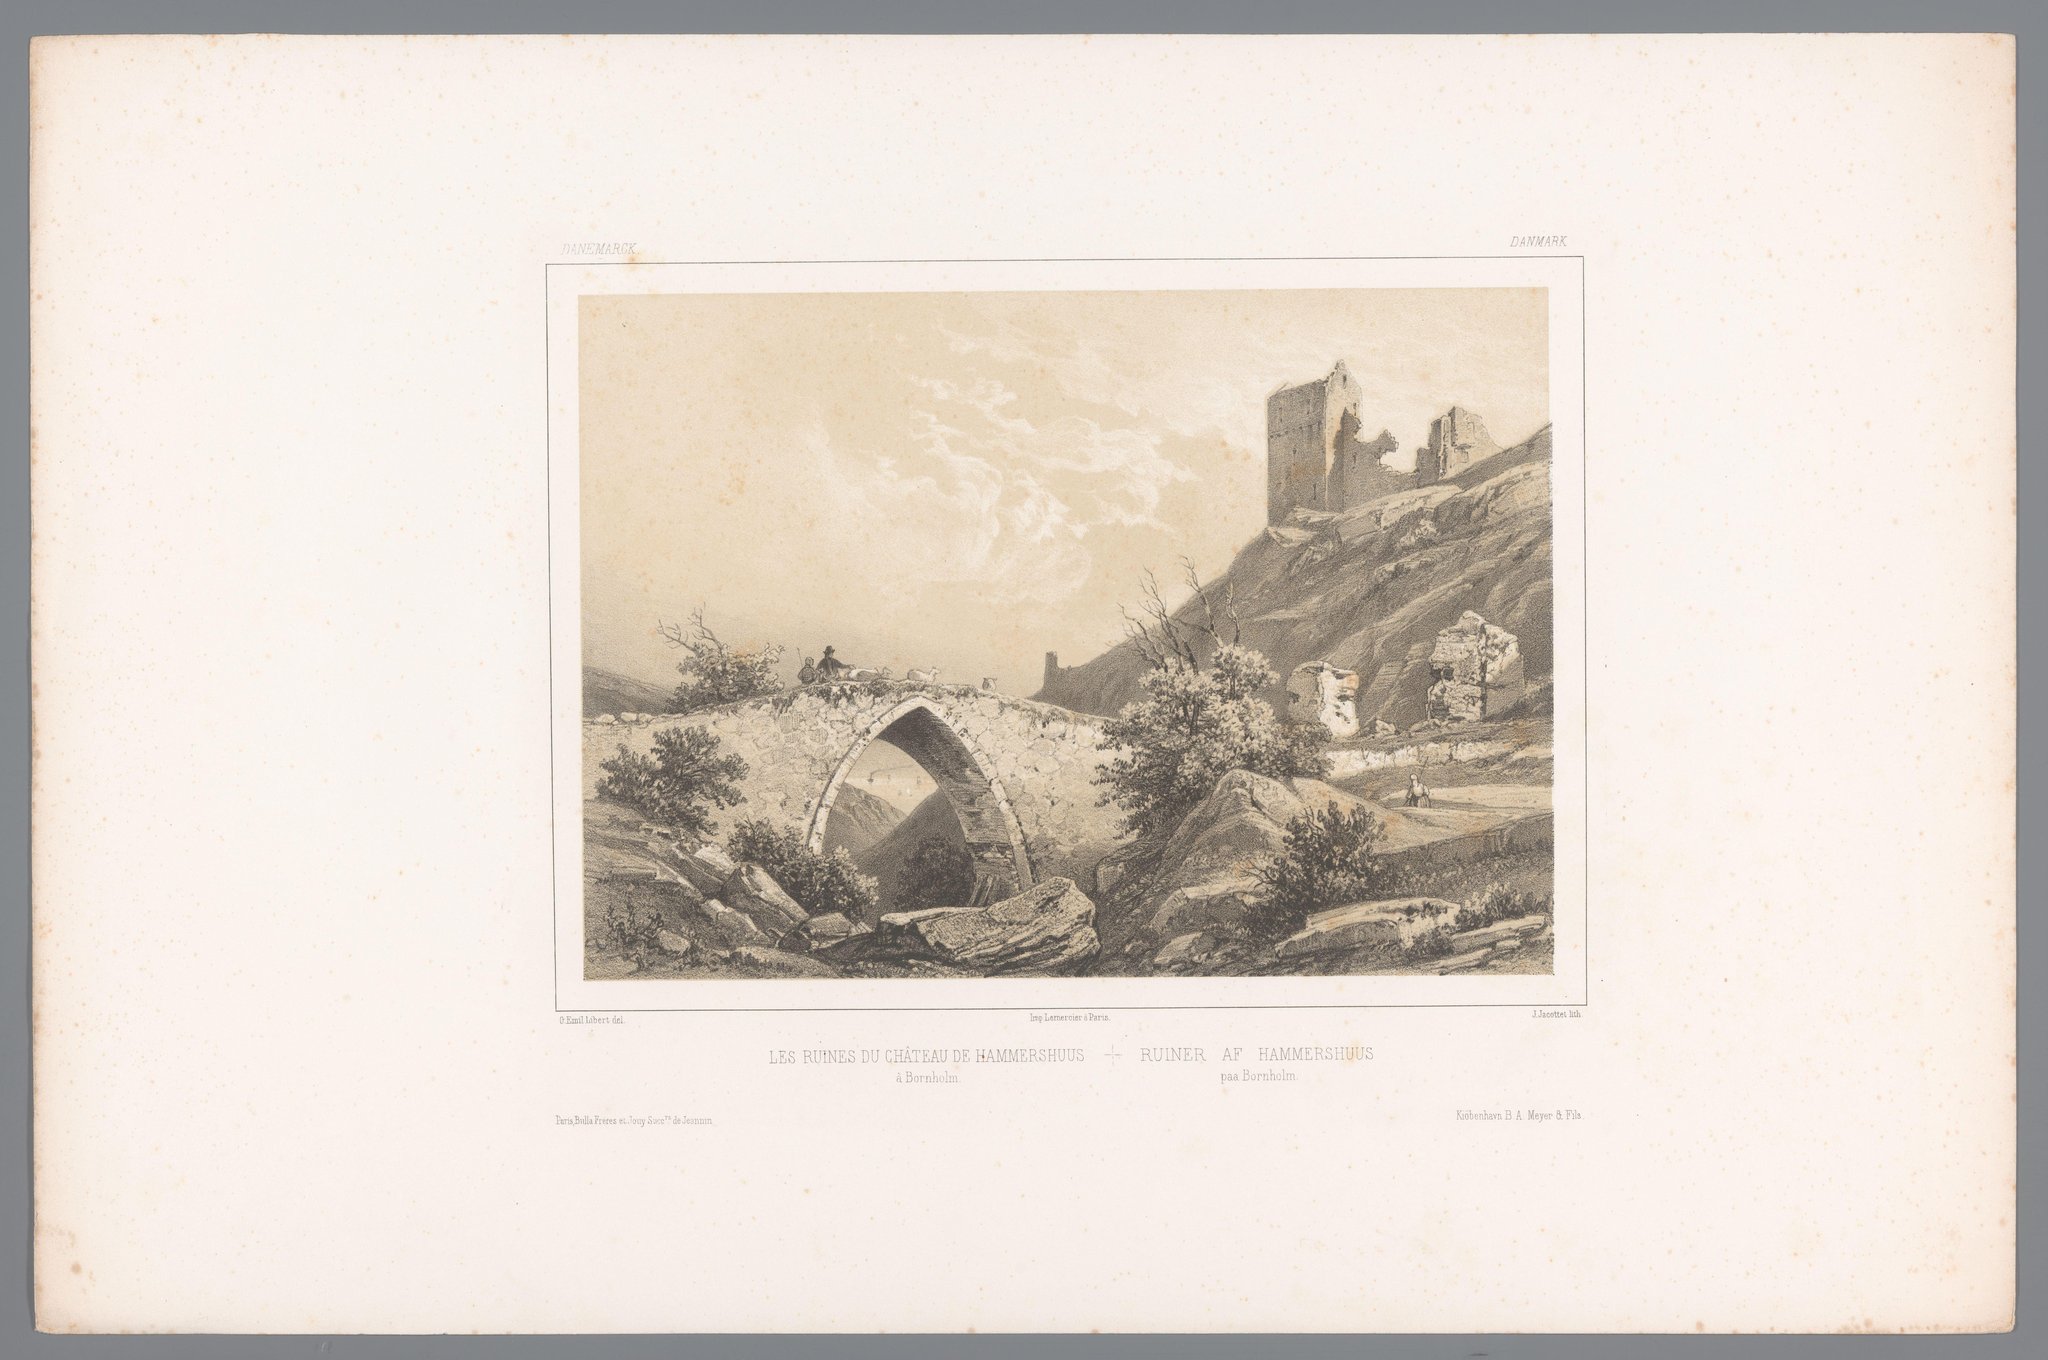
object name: print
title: Vues du Nord. Danemarck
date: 1851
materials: paper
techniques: tone lithography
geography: paris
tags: landscape with ruins, ruin of a dwelling, house, castle, etc.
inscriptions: collector's mark: Lugt 2228a